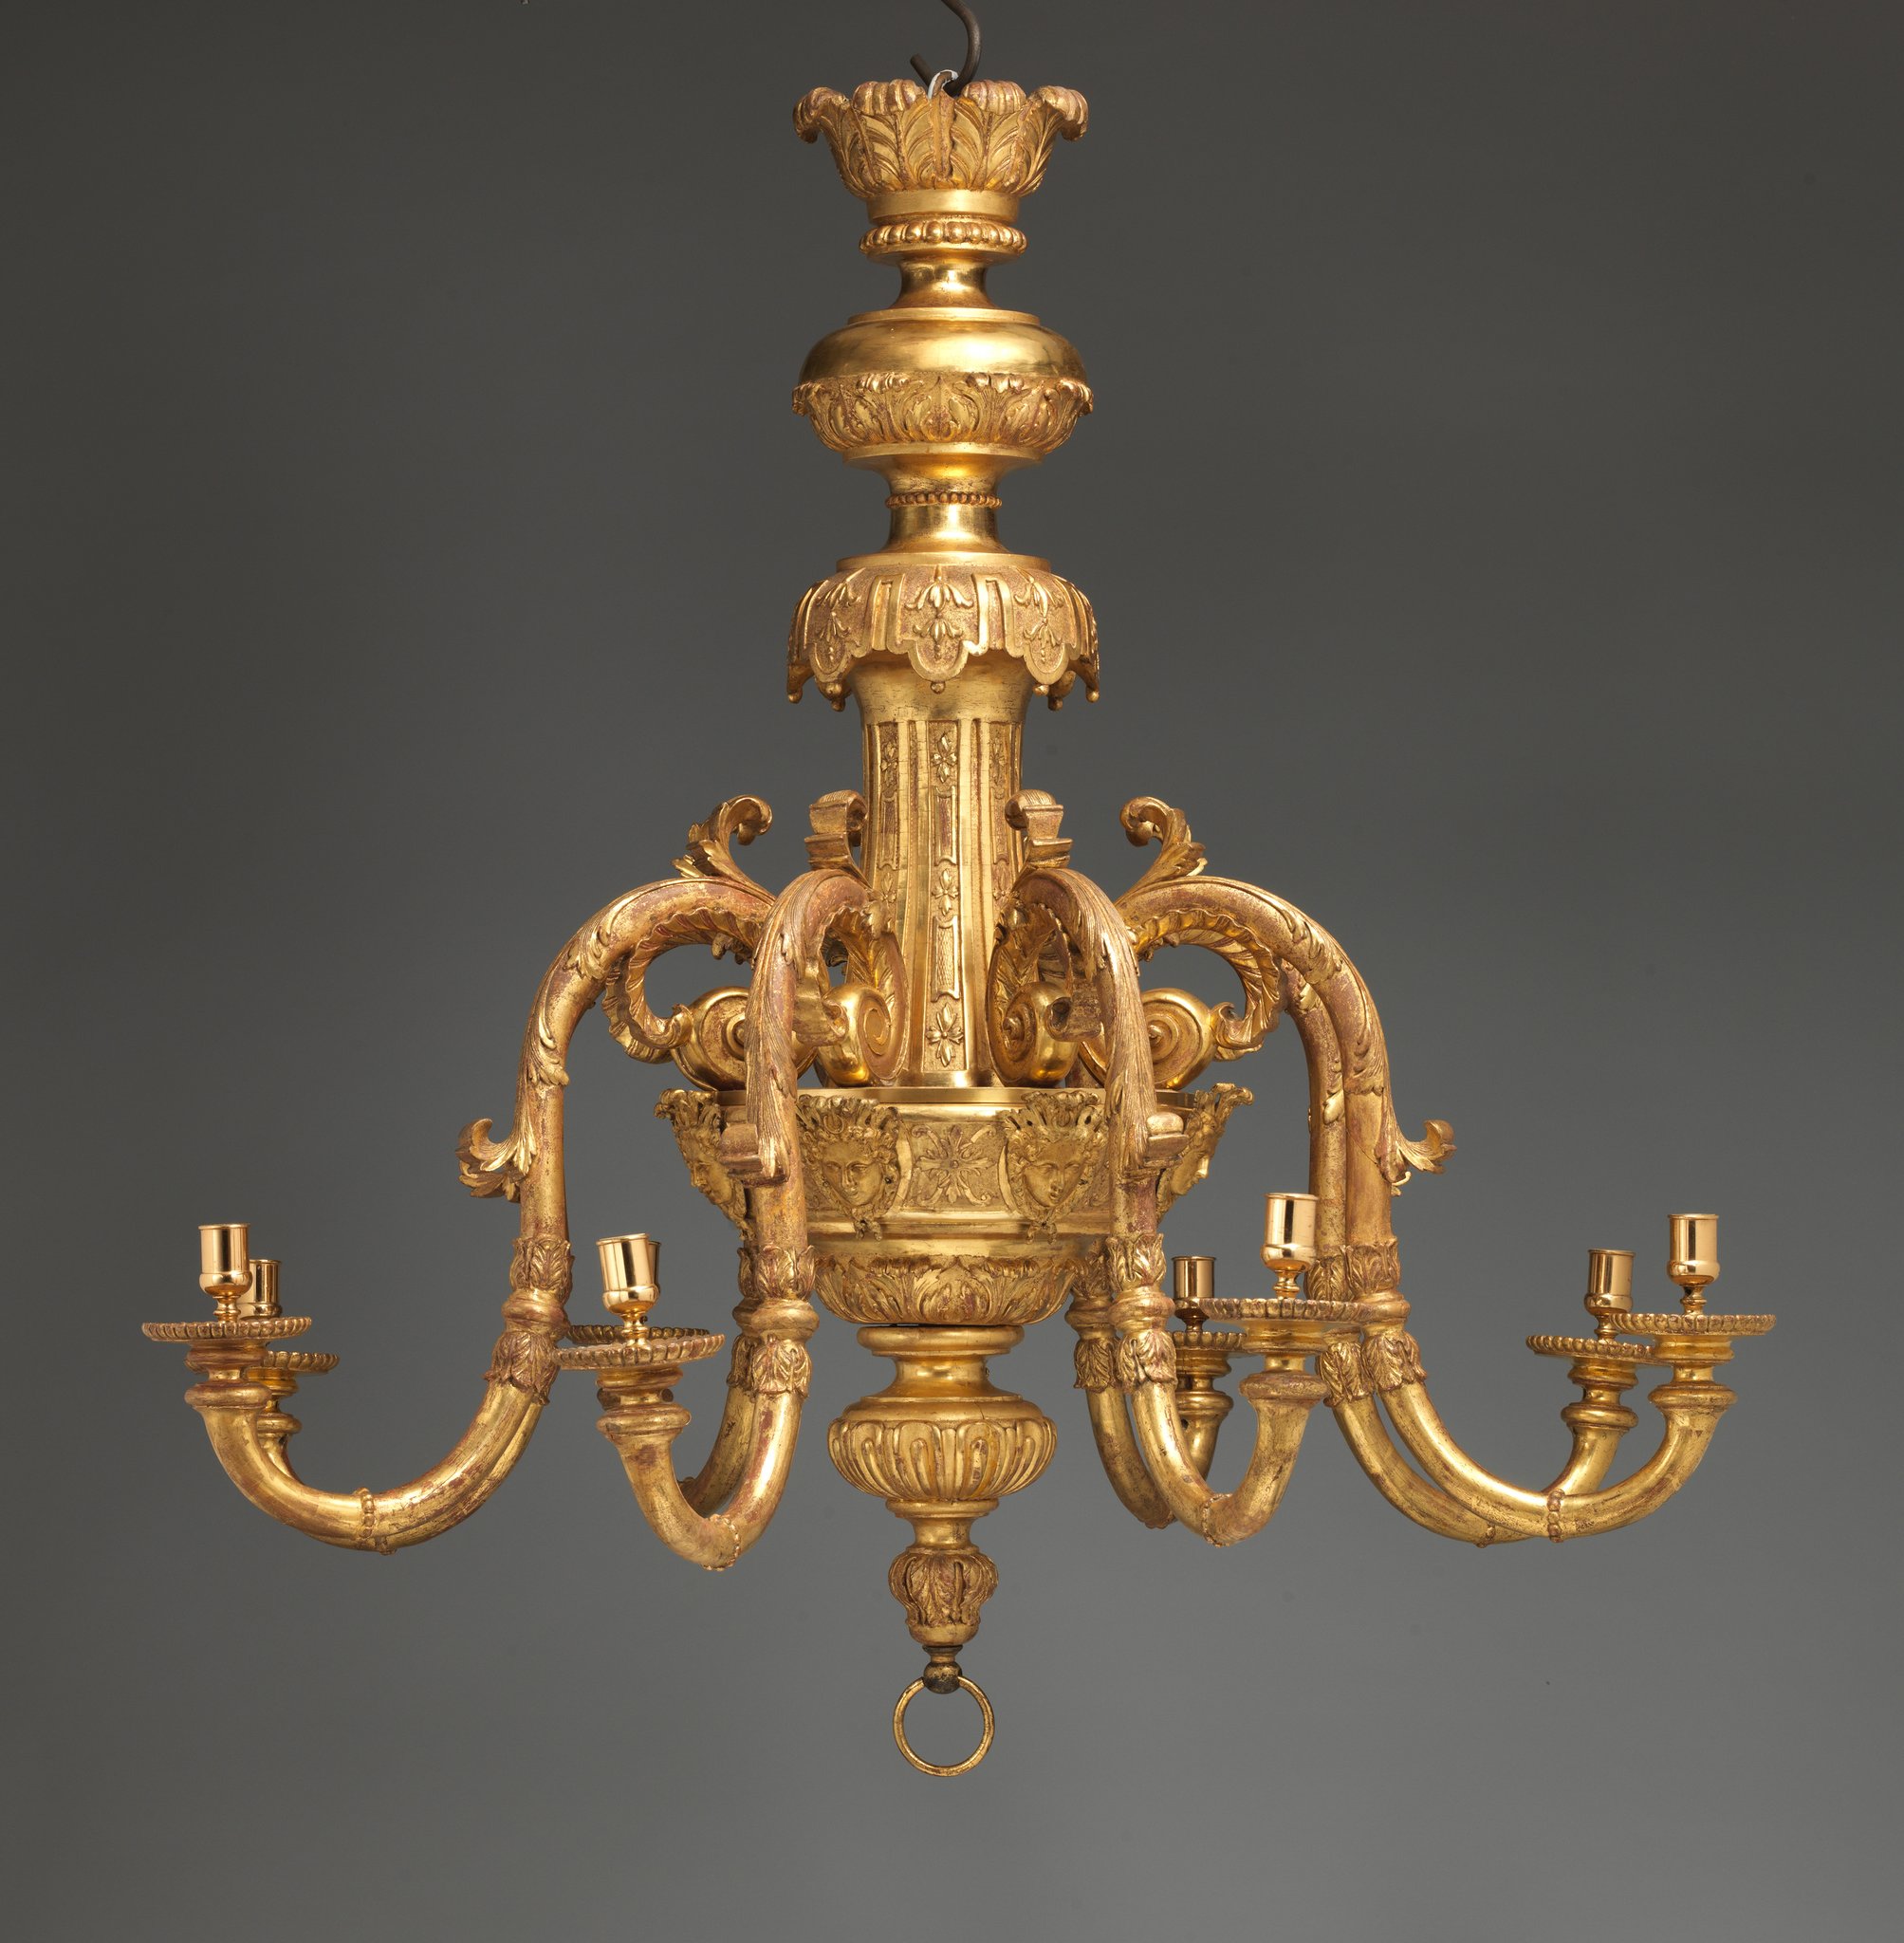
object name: chandelier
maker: john gumley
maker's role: maker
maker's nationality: british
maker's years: 1670-1726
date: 1710-1715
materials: gesso, metal, wood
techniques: gilding